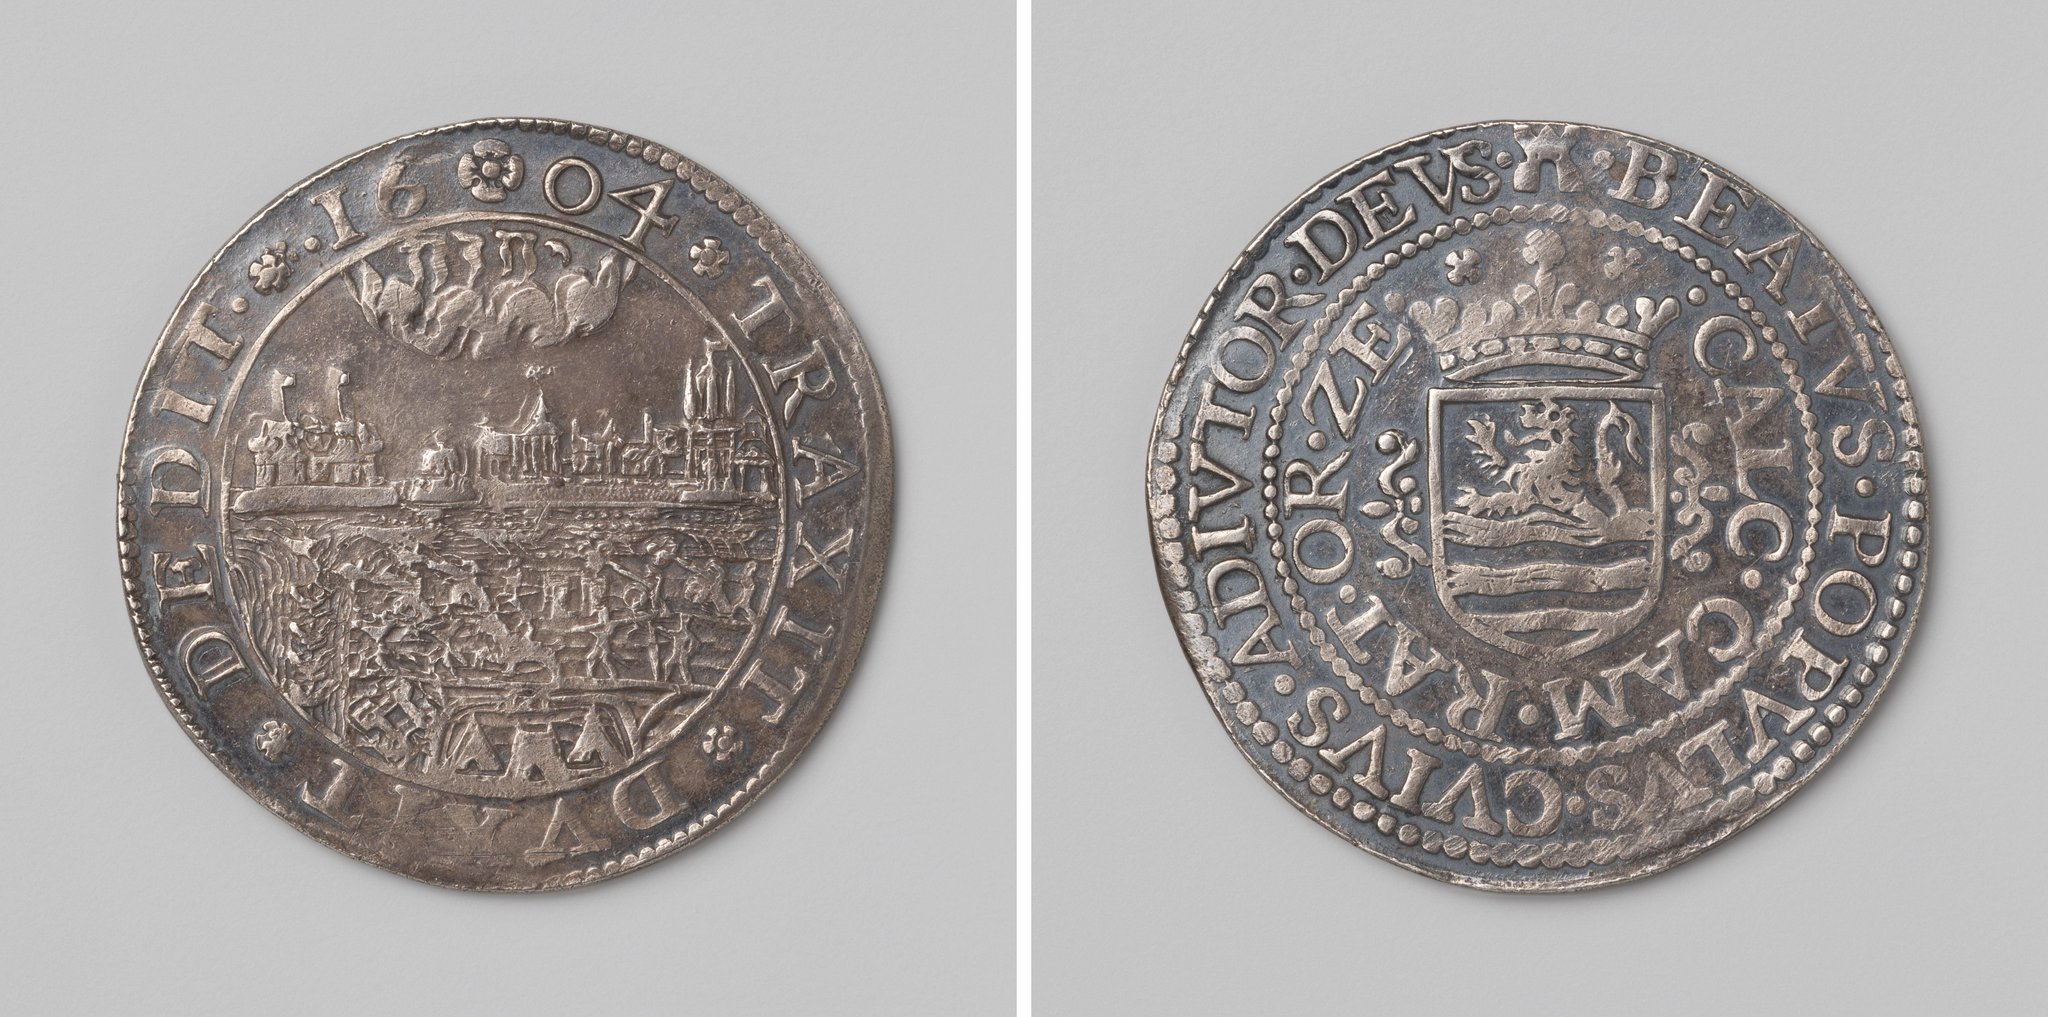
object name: jeton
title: Inname van Sluis met haven en vloot, rekenpenning van de rekenkamer van Zeeland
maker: Anonymous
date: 1604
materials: silver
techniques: striking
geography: middelburg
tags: zeeland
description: Zilveren penning. Voorzijde: gezicht op stad Sluis, haven, havenwerken en veroverde schepen; daarboven naam Jehova in Hebreeuws schrift in wolken binnen omschrift. Keerzijde: gekroond wapenschild binnen tweeregelig omschrift